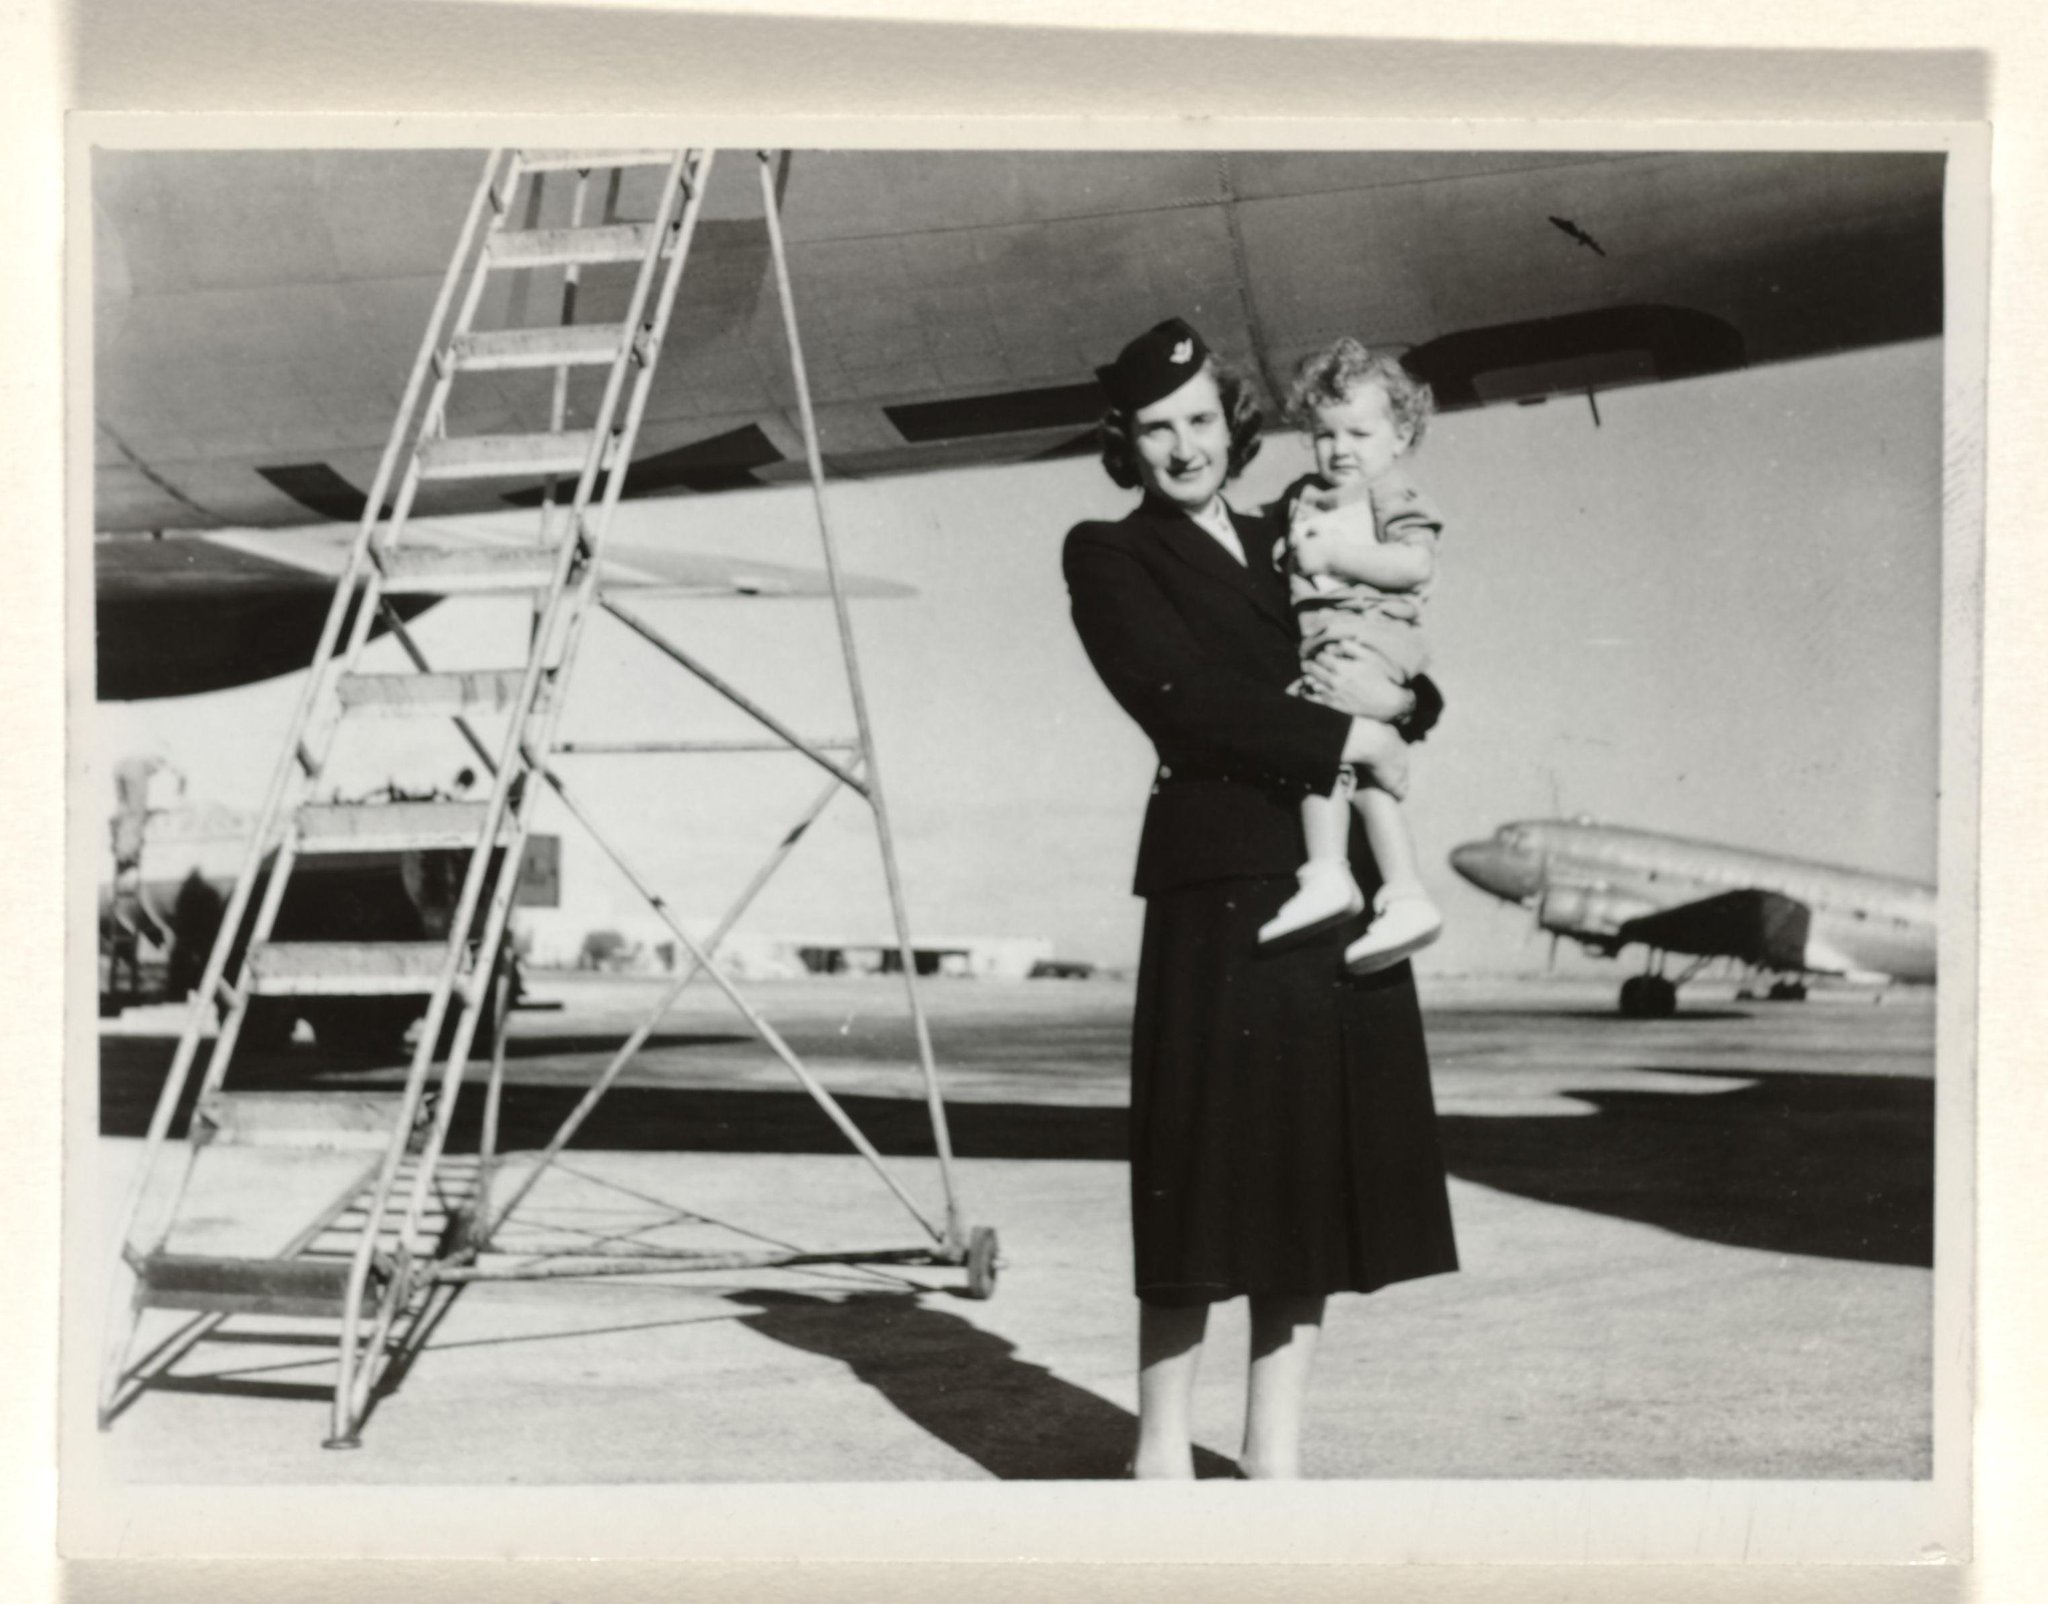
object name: photograph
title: Isabel Wachenheimer in uniform van de KLM, staand naast een trap envoor een vliegtuig, met een kind op haar arm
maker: Anonymous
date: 1947-1955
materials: photographic support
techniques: gelatin silver print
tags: leiden, isabel wachenheimer-elon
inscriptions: number: ‘17IE/339’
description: Isabel Wachenheimer in uniform van de KLM, staand naast een trap envoor een vliegtuig, met een kind op haar arm.